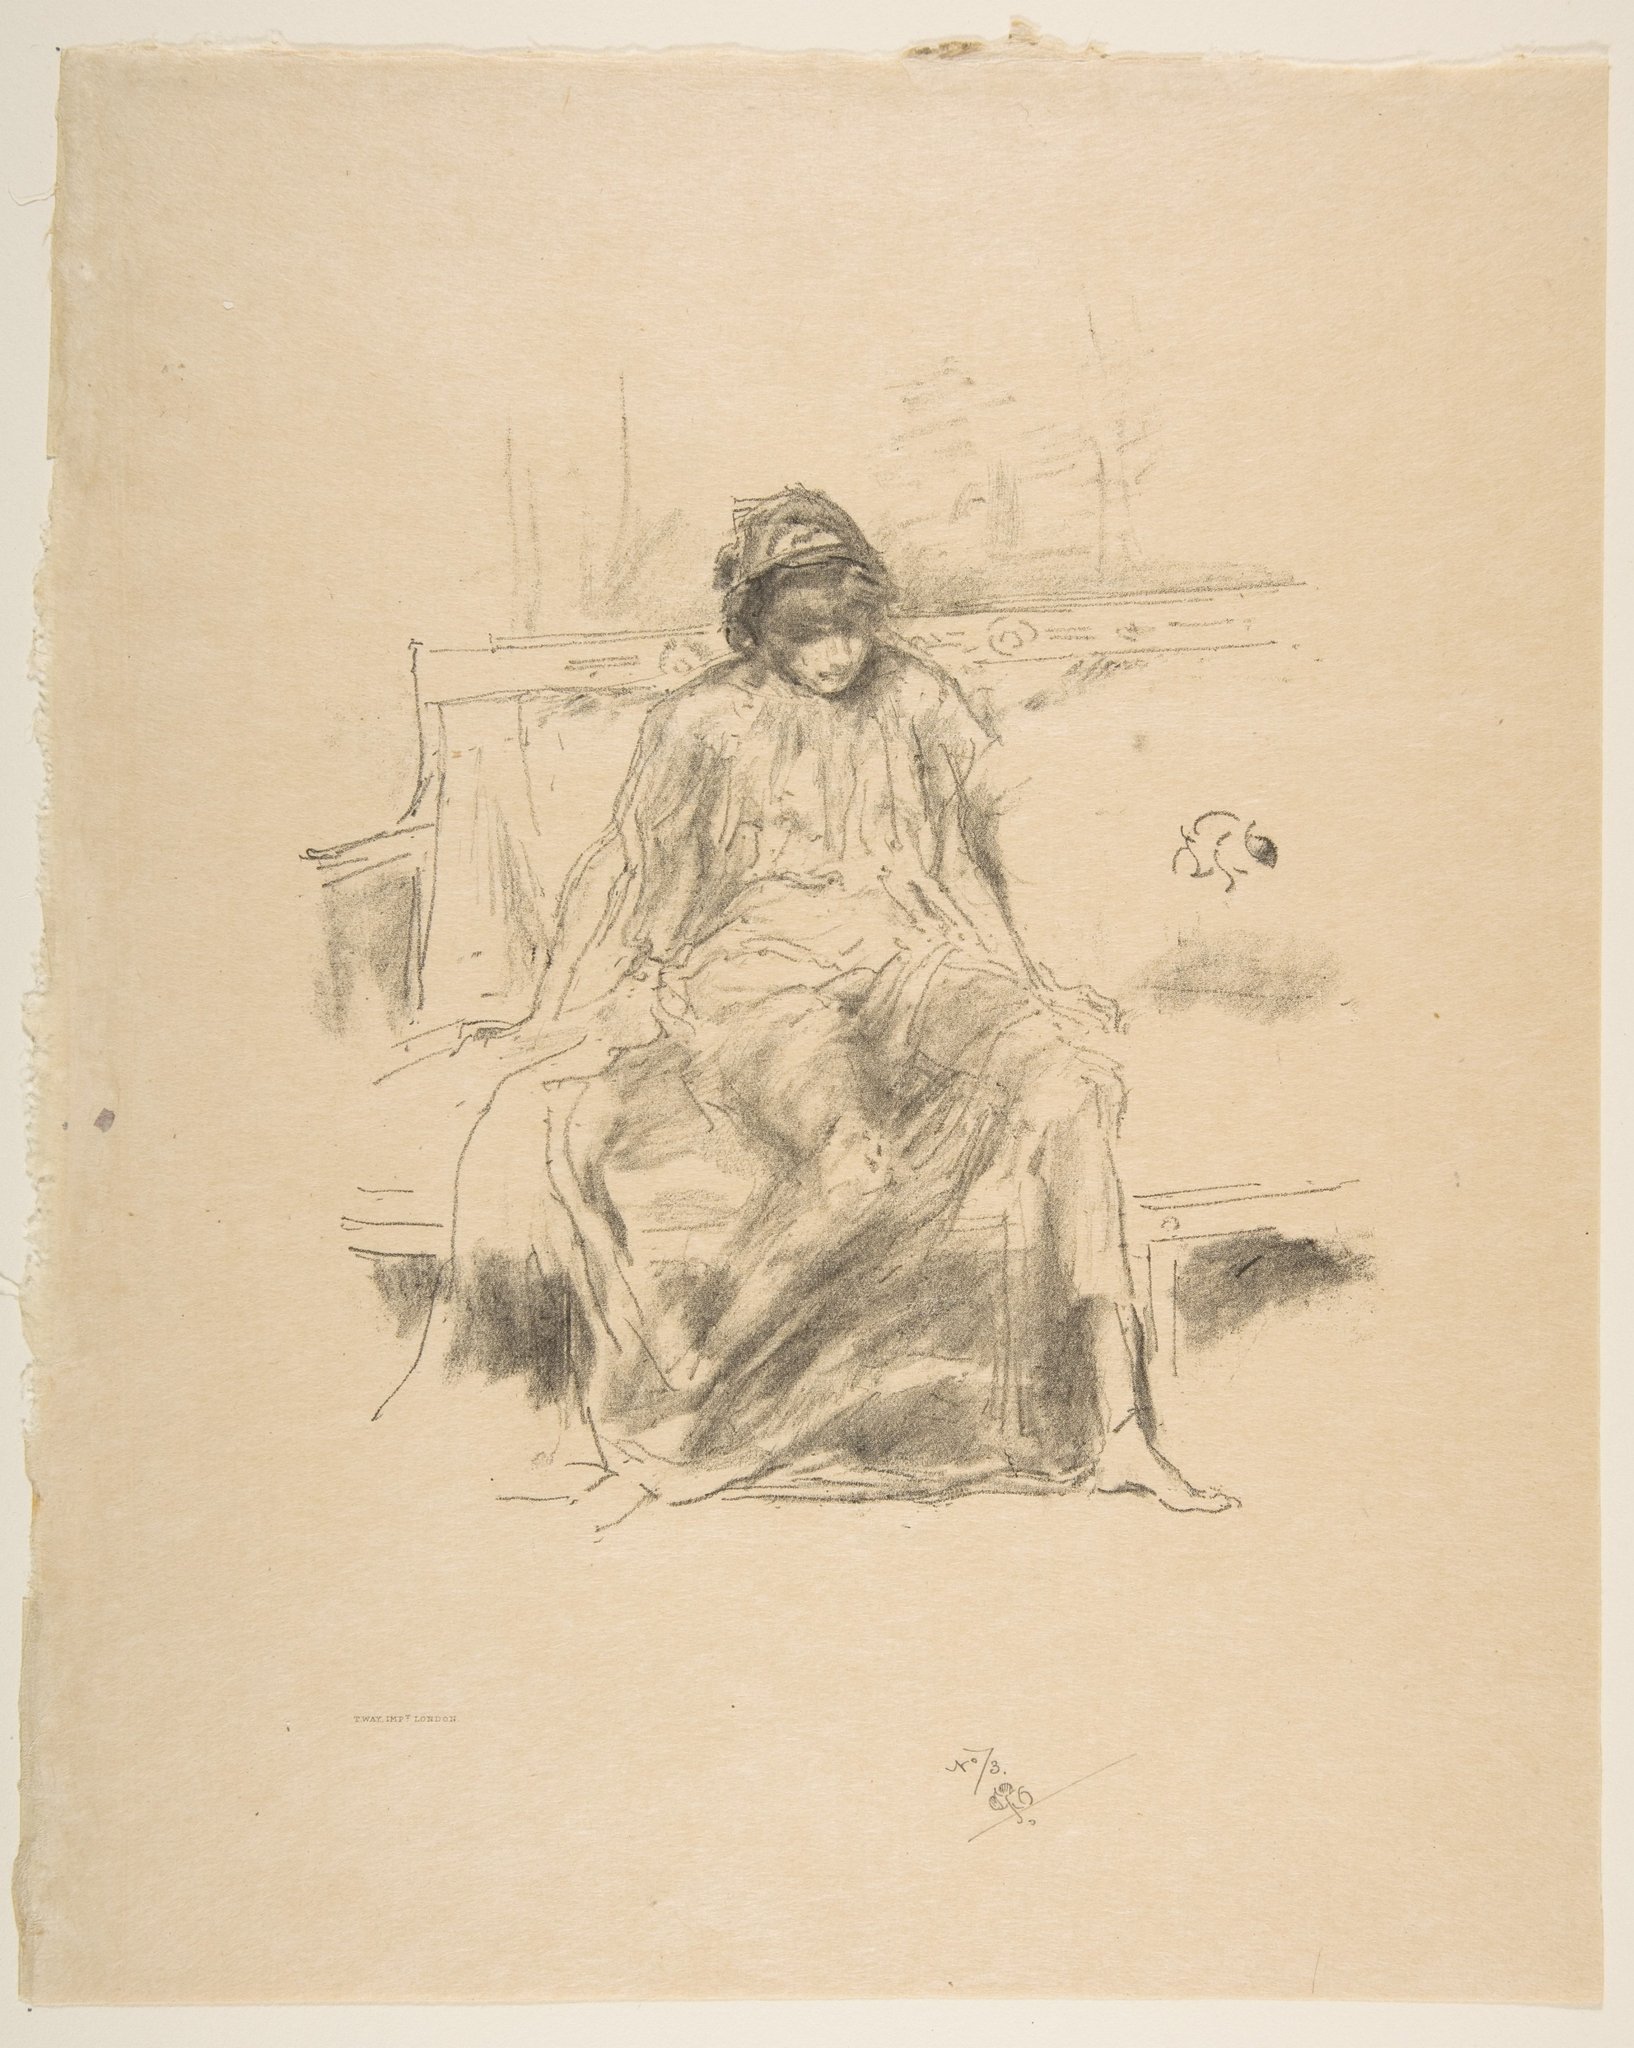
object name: print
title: The Draped Figure Seated, from "L'Estampe Originale"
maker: james mcneill whistler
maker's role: artist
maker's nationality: american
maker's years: 1834-1903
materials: ink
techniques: printing, stumping, lithography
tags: human figures